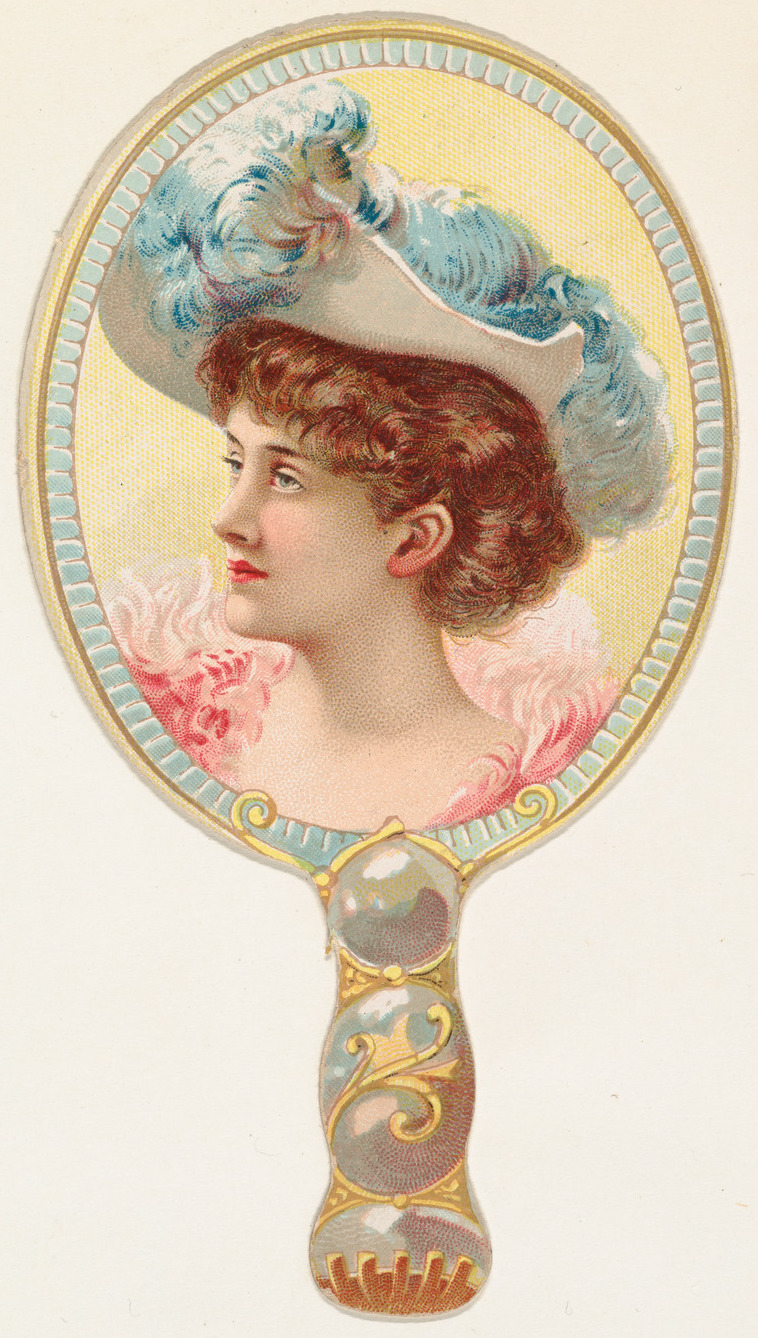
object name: print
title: Hand mirror with woman in blue feathered hat, from the Novelties series (N122) issued by Gail & Ax Tobacco to promote Navy Long Cut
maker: gail & ax tobacco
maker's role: publisher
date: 1889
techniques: color lithograph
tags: profiles,women,mirrors